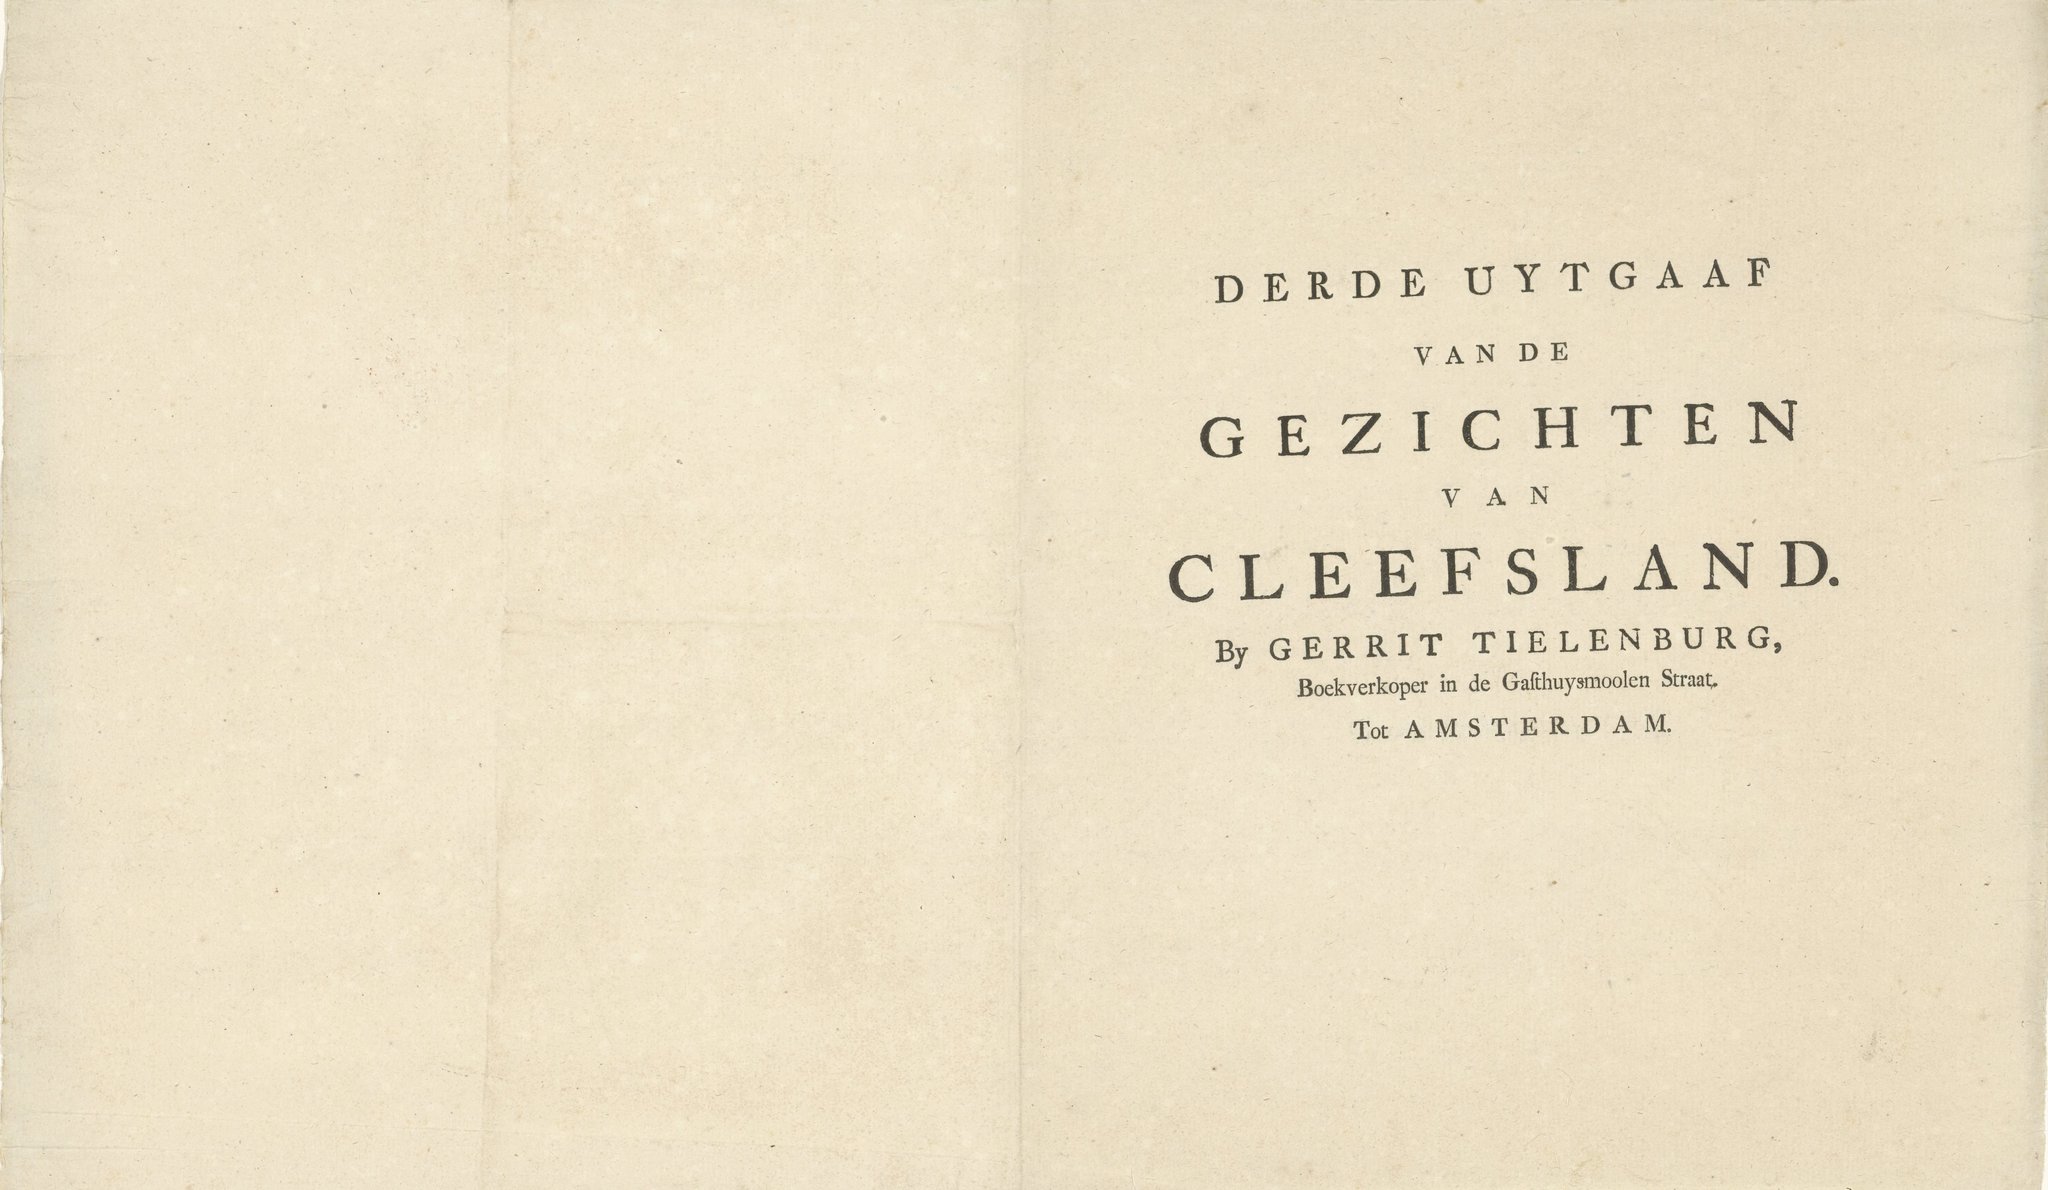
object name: text sheet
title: Titelpagina voor: Derde Uytgaaf van de Gezichten van Cleefsland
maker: gerrit tielenburg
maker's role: publisher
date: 1734-1774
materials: paper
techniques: letterpress printing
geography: amsterdam